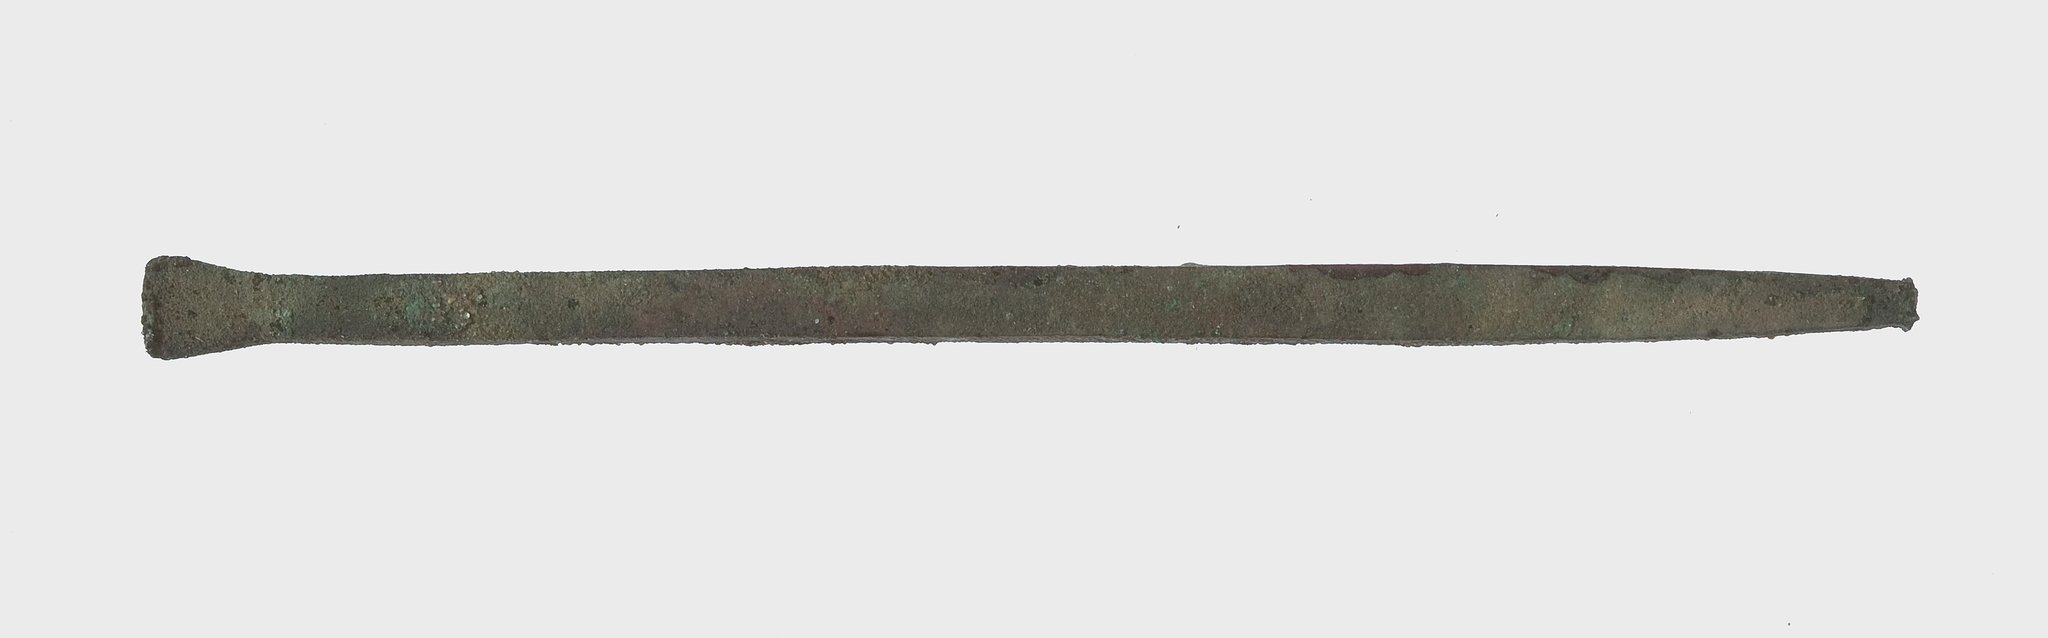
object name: chisel, carpenter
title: Carpenter's Chisel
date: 1390-1352 BCE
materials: bronze, copper alloy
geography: egypt